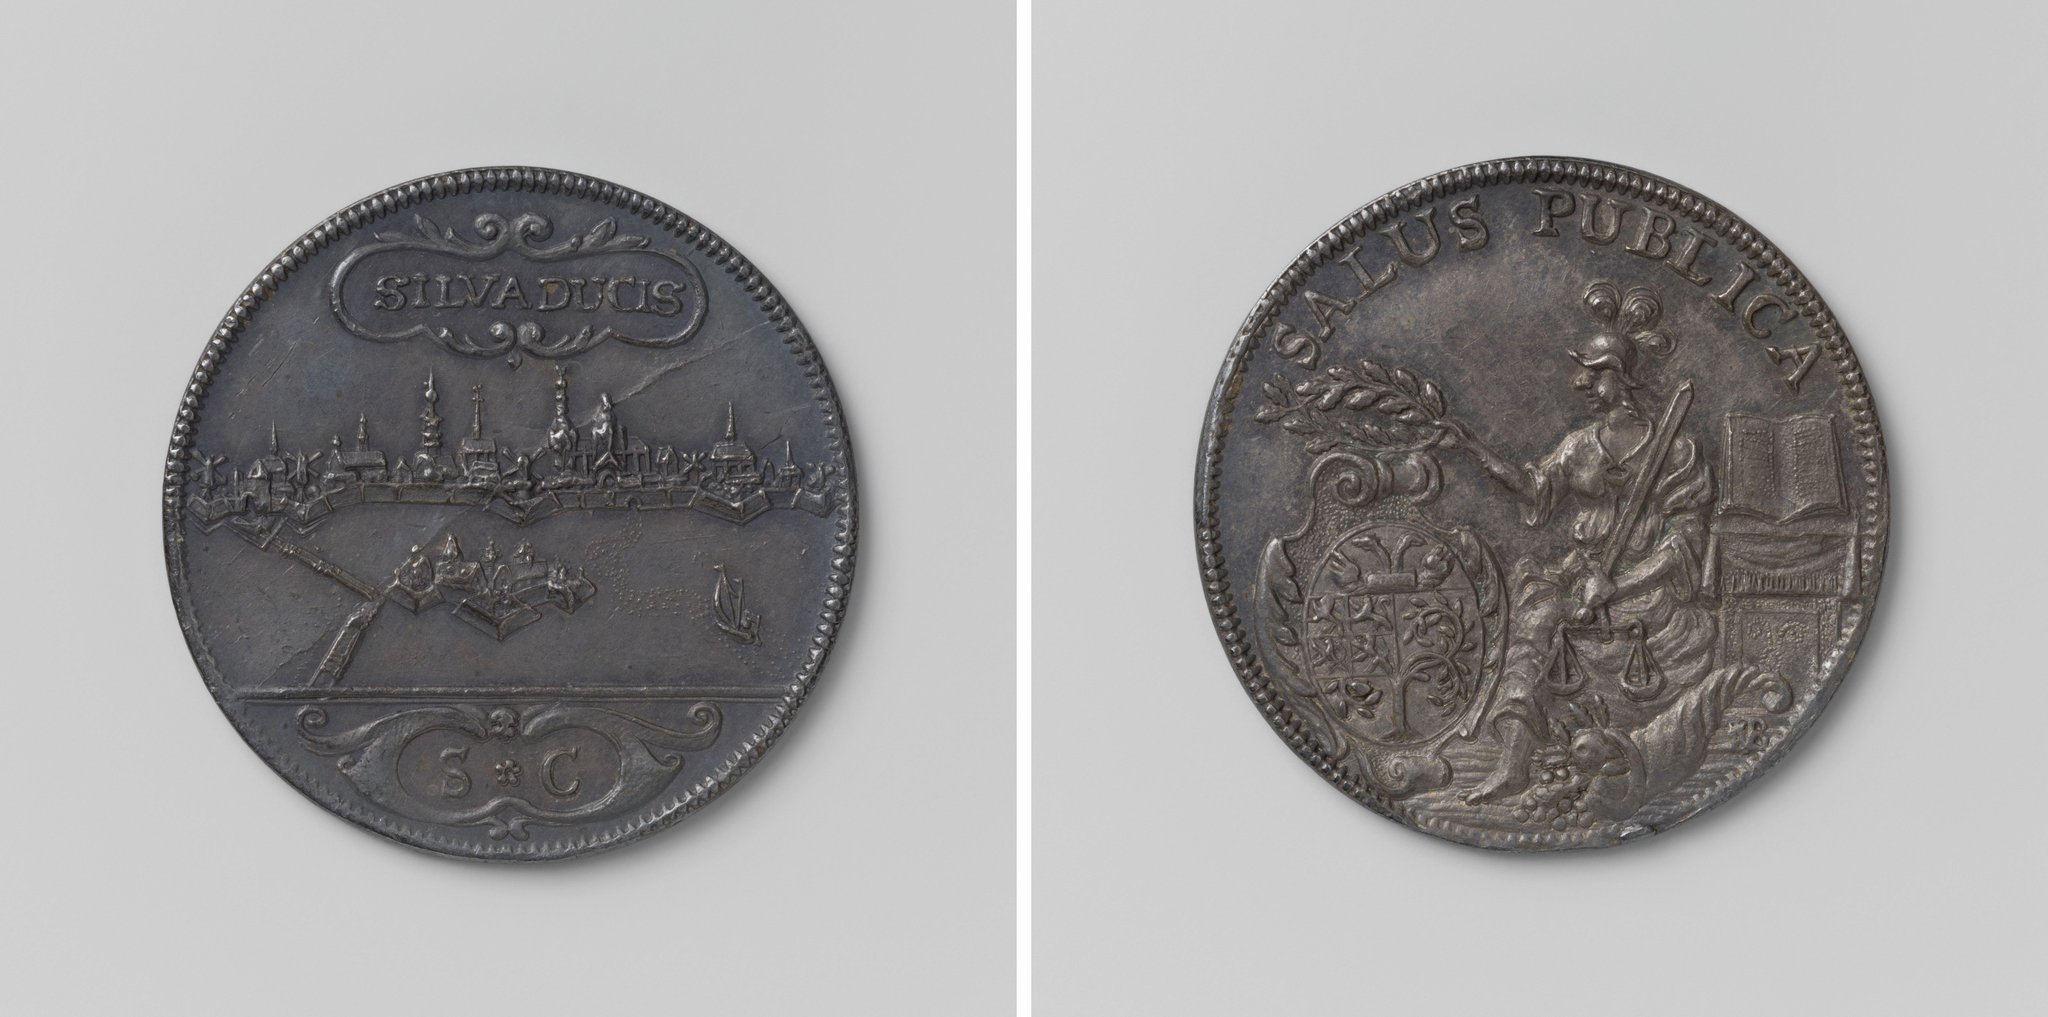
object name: council medal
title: Vroedschapspenning van de stad 's-Hertogenbosch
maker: theodorus casparus van berckel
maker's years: 1680-1734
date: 1712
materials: silver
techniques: striking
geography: den bosch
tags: den bosch